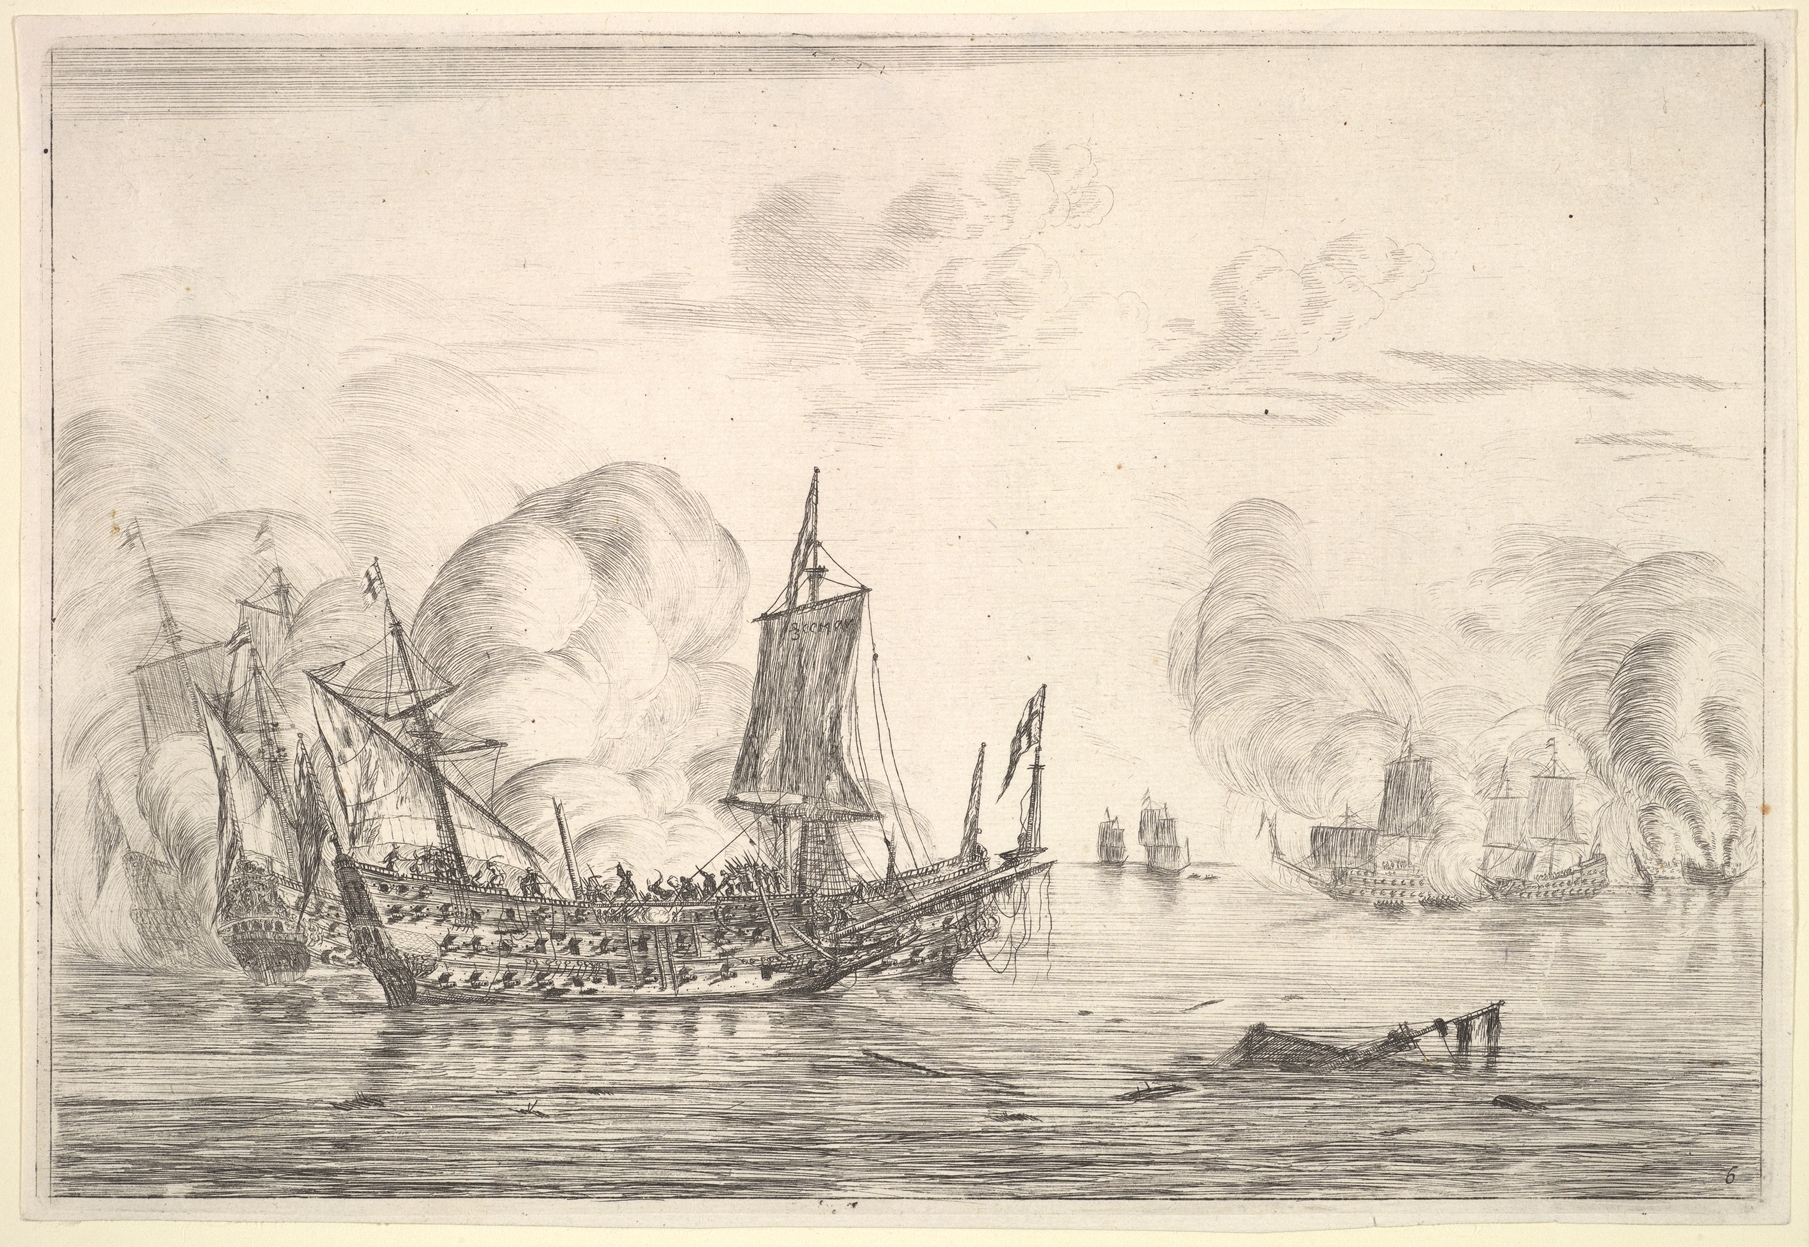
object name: print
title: The Final of a Naval Battle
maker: reinier nooms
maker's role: artist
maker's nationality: dutch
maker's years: 1623-1664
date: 1601-1700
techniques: etching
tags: battles,ships